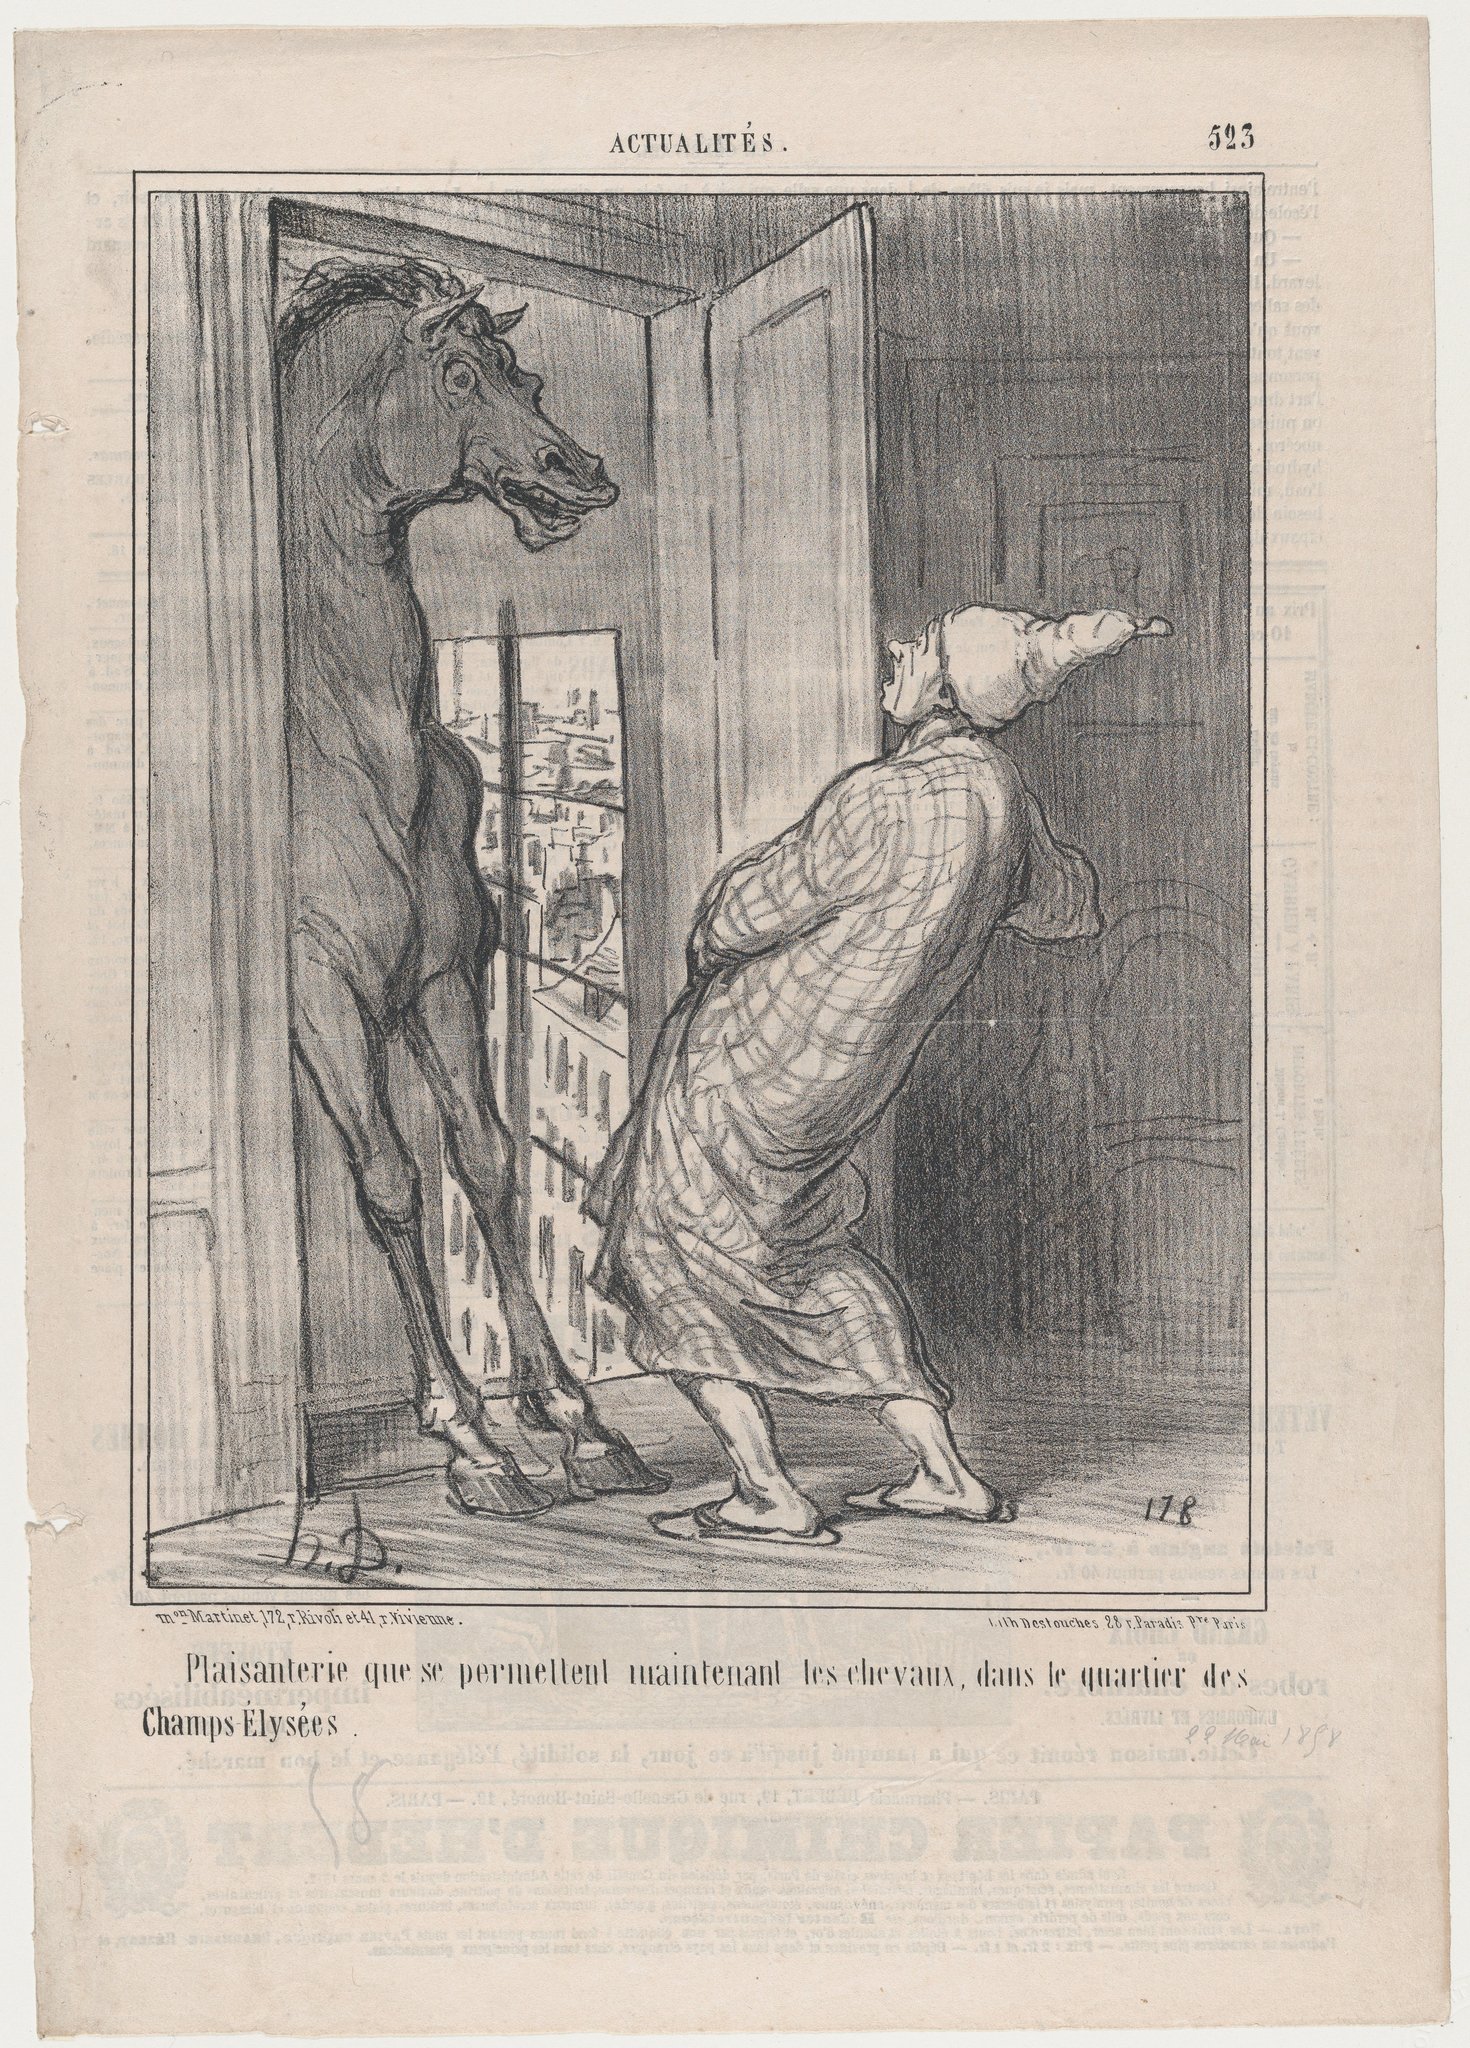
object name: print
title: Plaisanterie que se permettent maintenant les chevaux, dans le quatier des Champs-Élysées, No. 523 from series Actualités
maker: honoré daumier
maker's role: artist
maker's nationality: french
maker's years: 1808-1879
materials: paper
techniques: lithograph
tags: men,horses